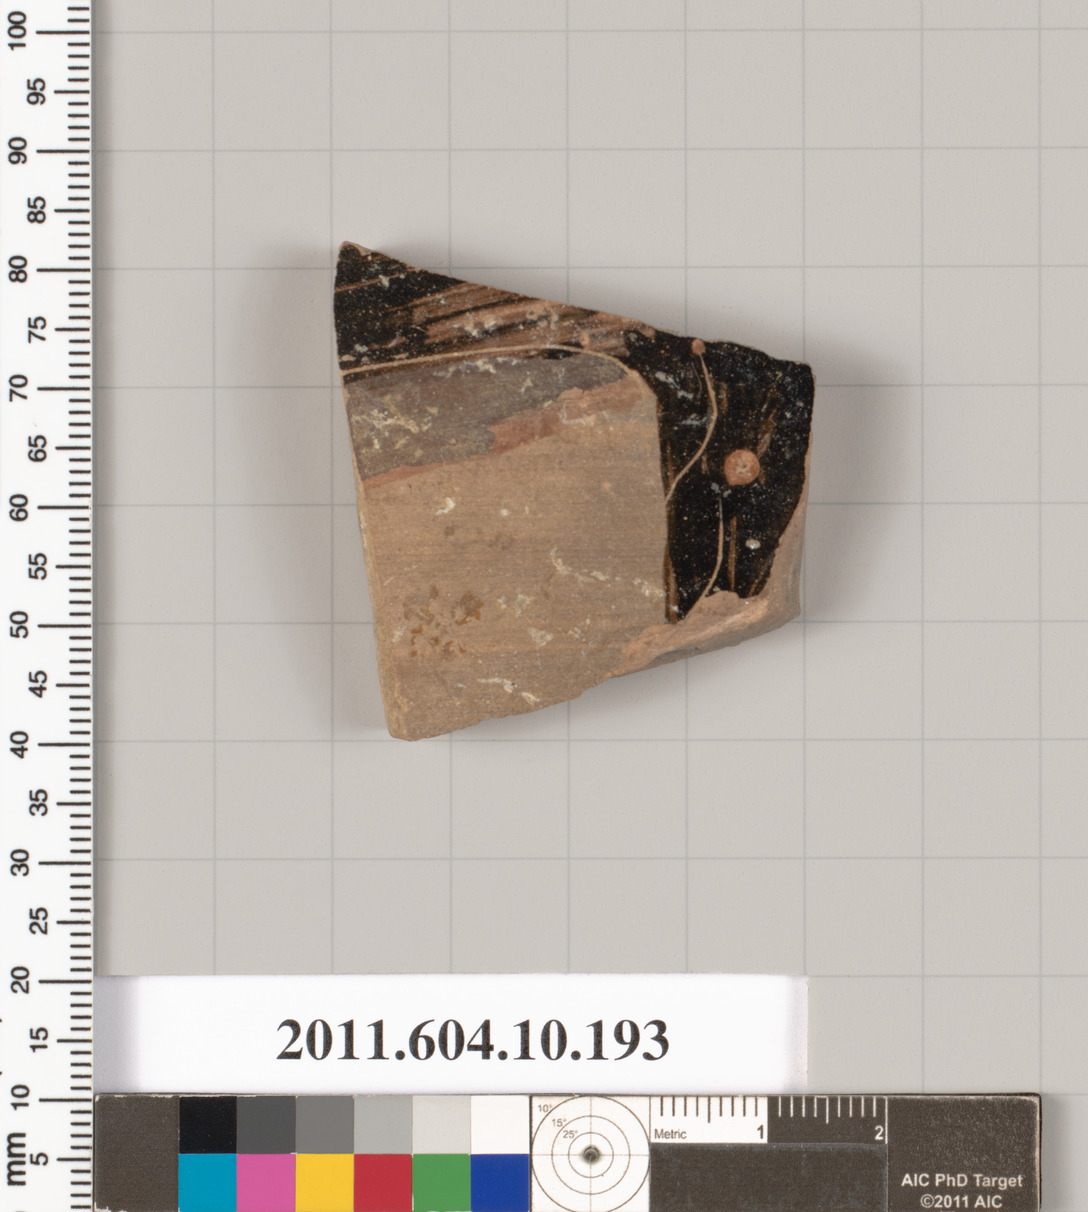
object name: undetermined closed shape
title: Terracotta fragment from a closed shape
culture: etruscan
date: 534-468 BCE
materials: terracotta